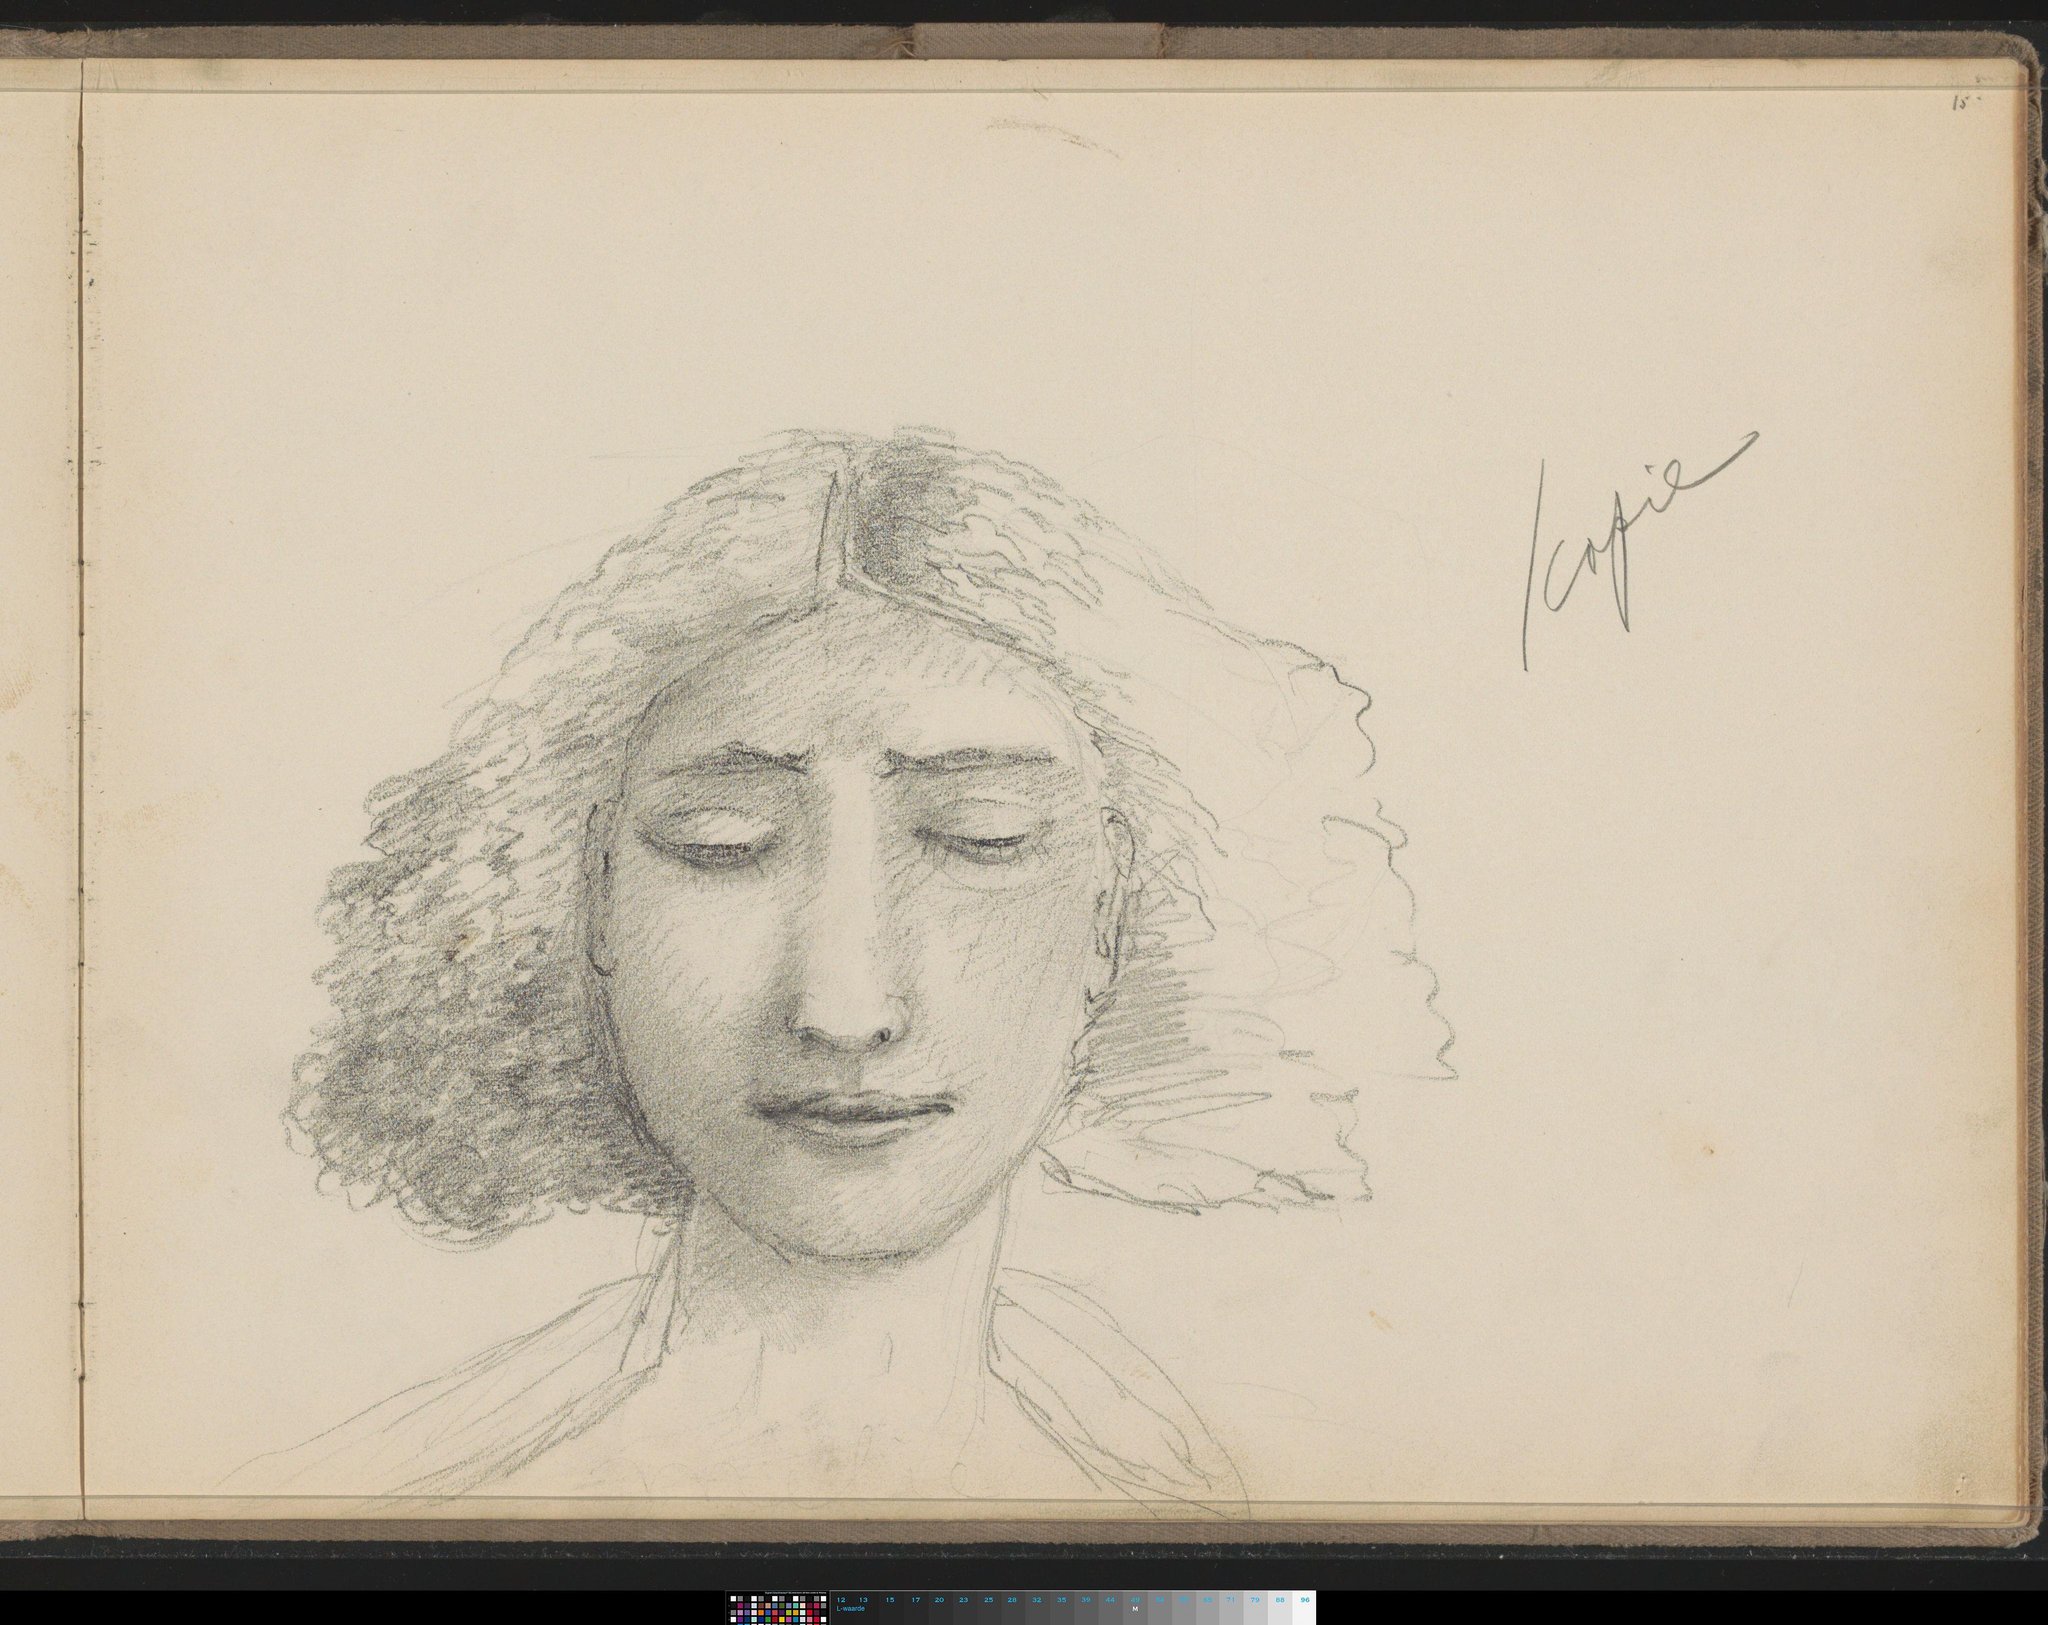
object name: sketchbook leaf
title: Portret van een vrouw met gesloten ogen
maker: chris huidekooper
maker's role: draughtsman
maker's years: 1878-1939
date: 1895-1896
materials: chalk, paper, pencil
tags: anonymous historical person portrayed, eyes closed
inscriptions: annotation: ‘Kopie’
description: Blad 15 recto uit een schetsboek met 32 bladen.